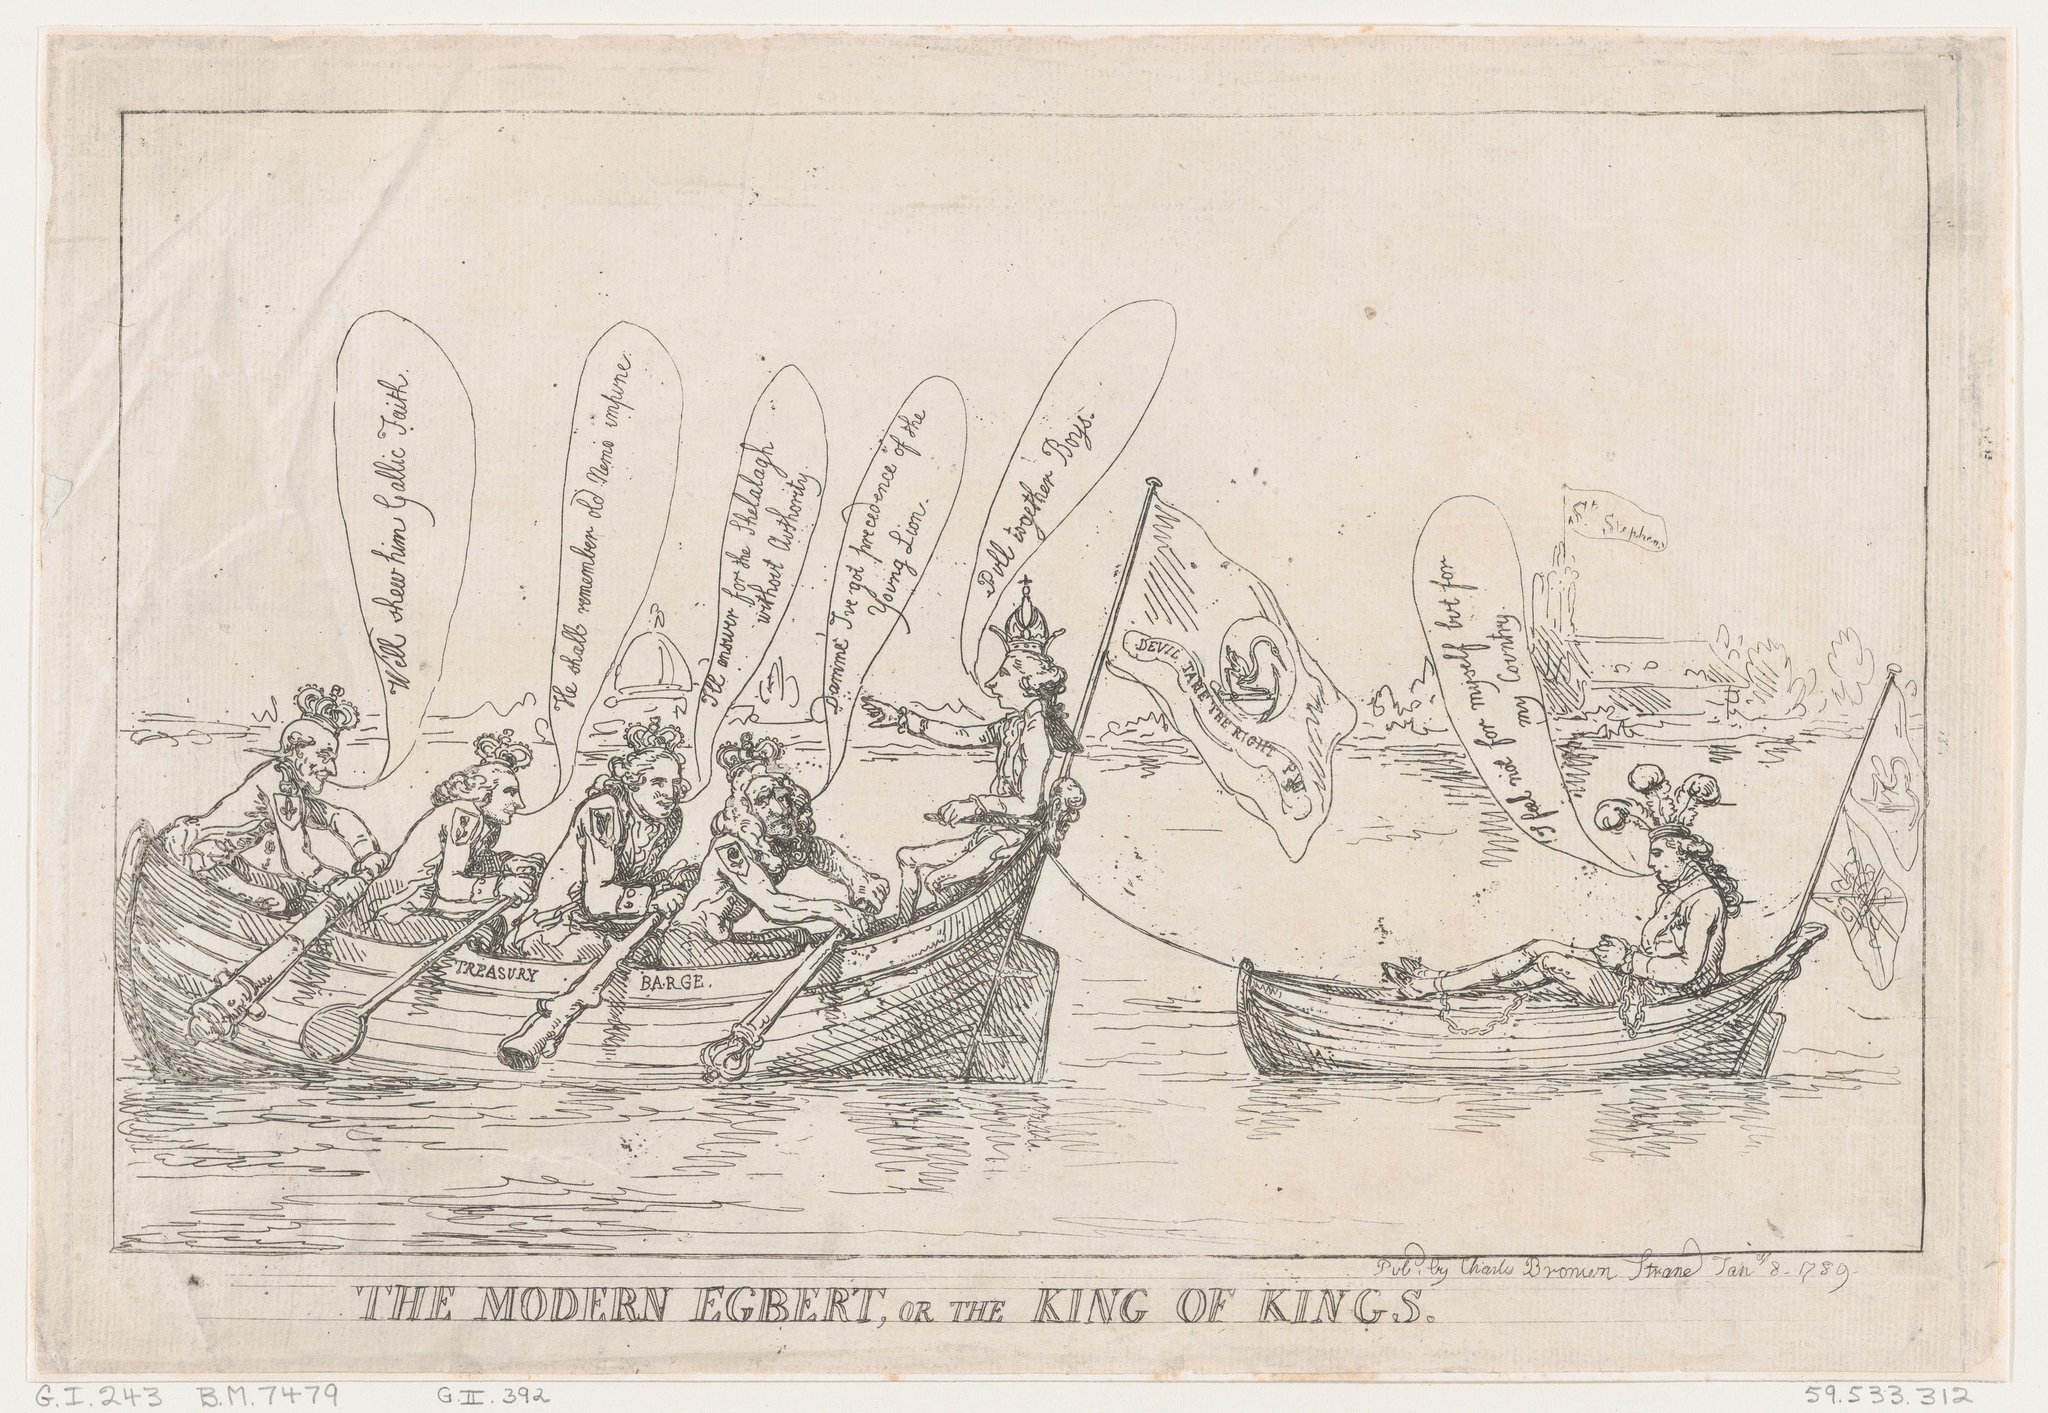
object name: print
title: The Modern Egbert, or The King of Kings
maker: thomas rowlandson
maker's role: artist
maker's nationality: british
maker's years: 1757-1827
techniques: etching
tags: satire,kings,men,sailing,boats